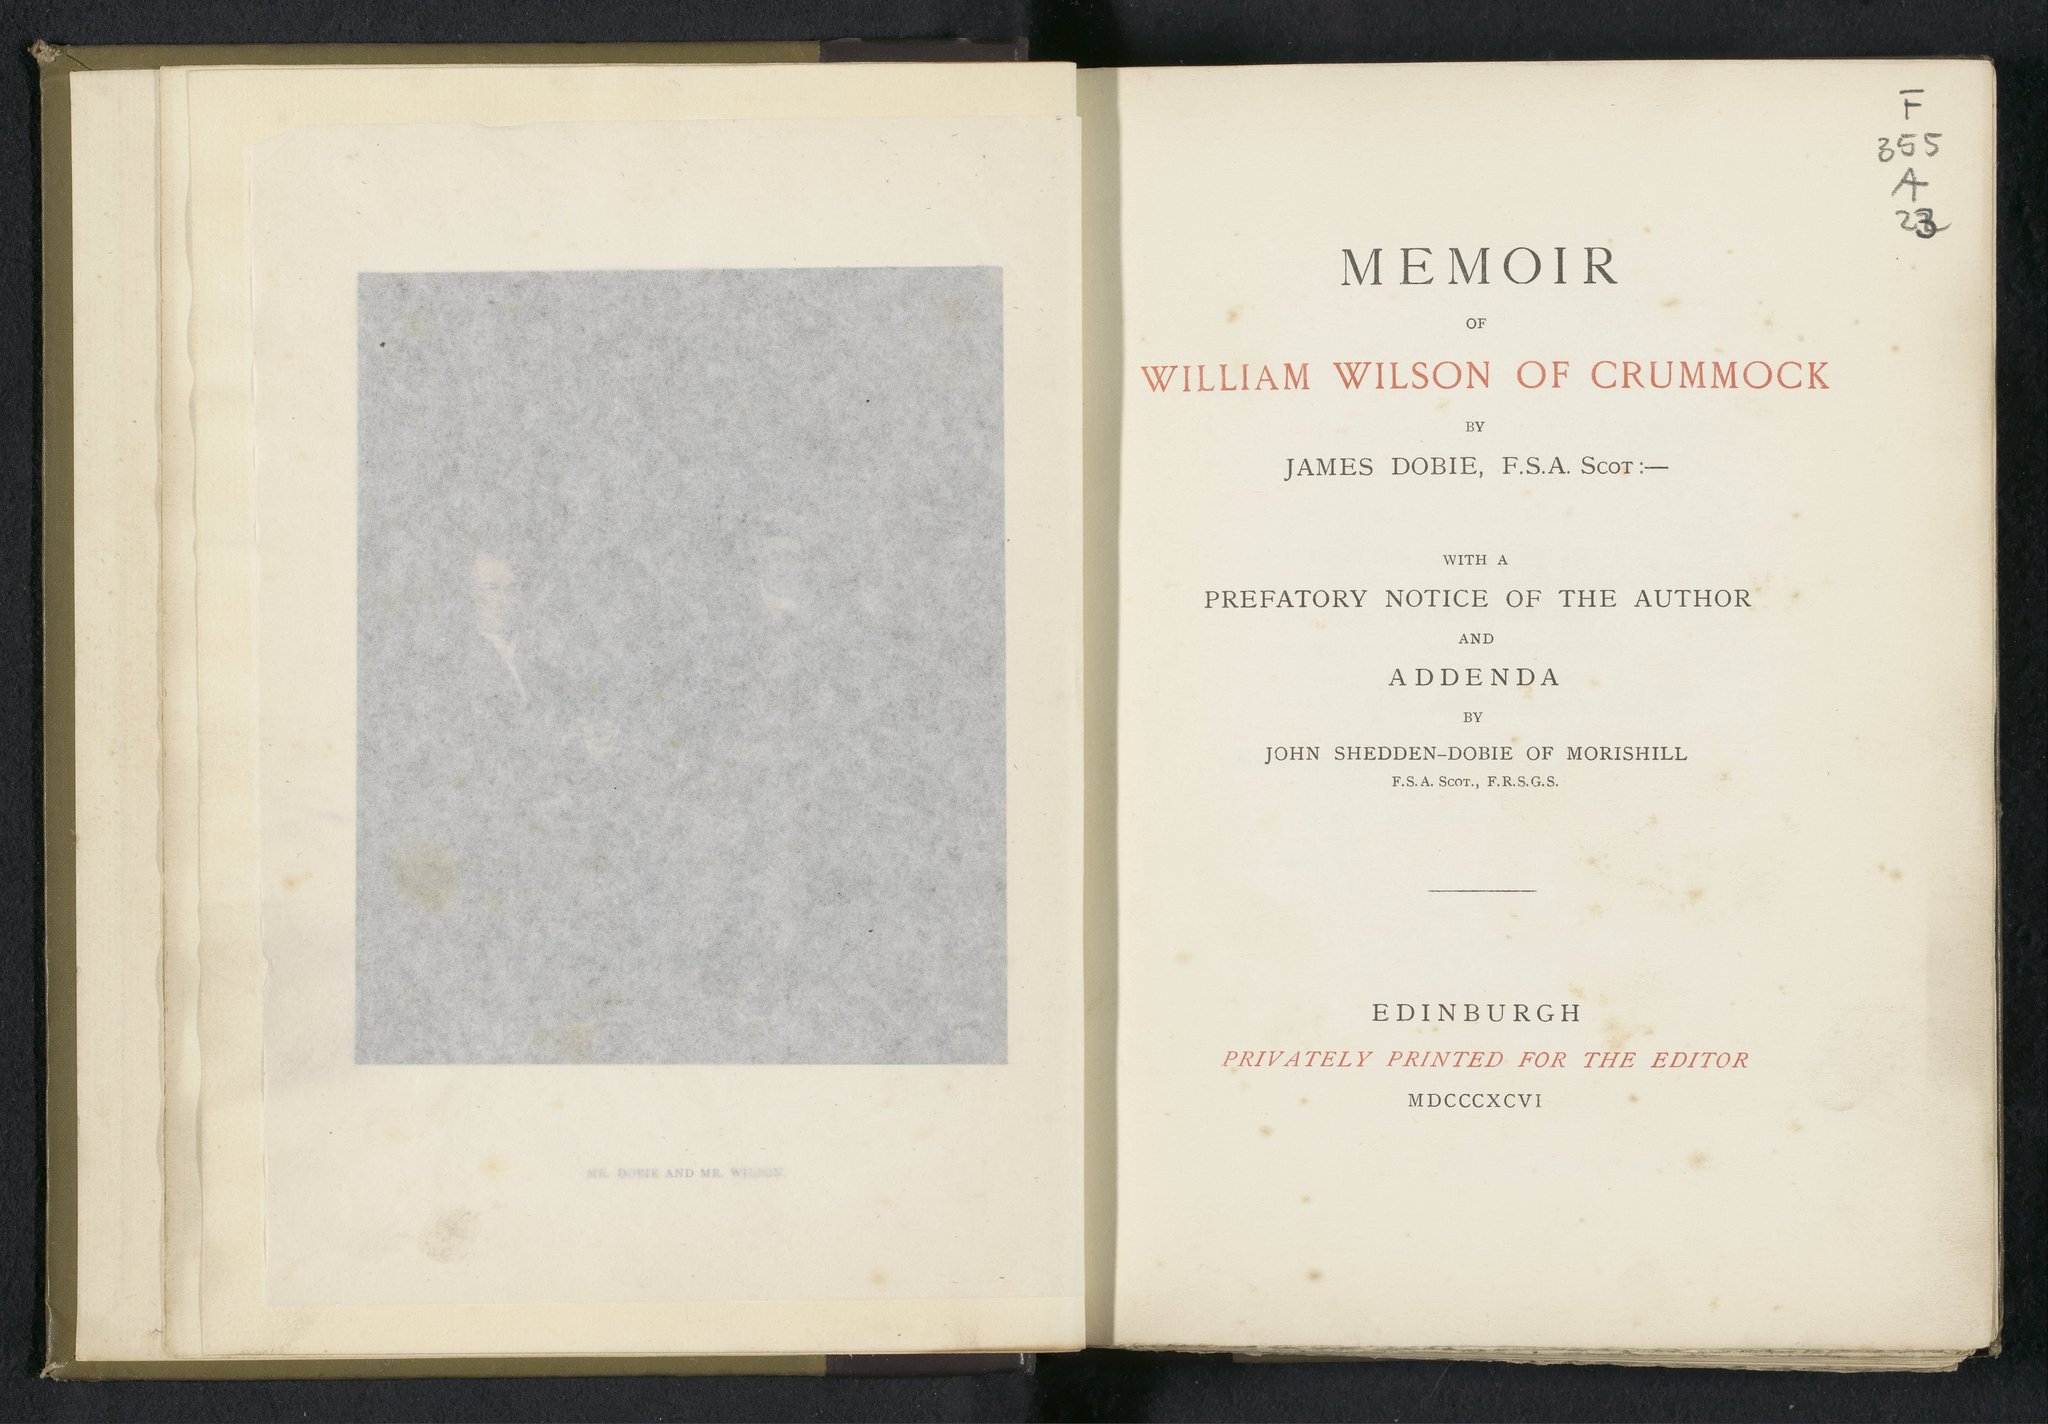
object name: book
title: Memoir of William Wilson of Crummock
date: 1896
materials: cardboard, linen, paper, photographic support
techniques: carbon print, platinum process, printing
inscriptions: annotation, inscription: ‘No. 5 Robert Dobie Wilson Esq. with the Editor's kind regards received April 1897’, inscription: ‘R.D. Wilson’